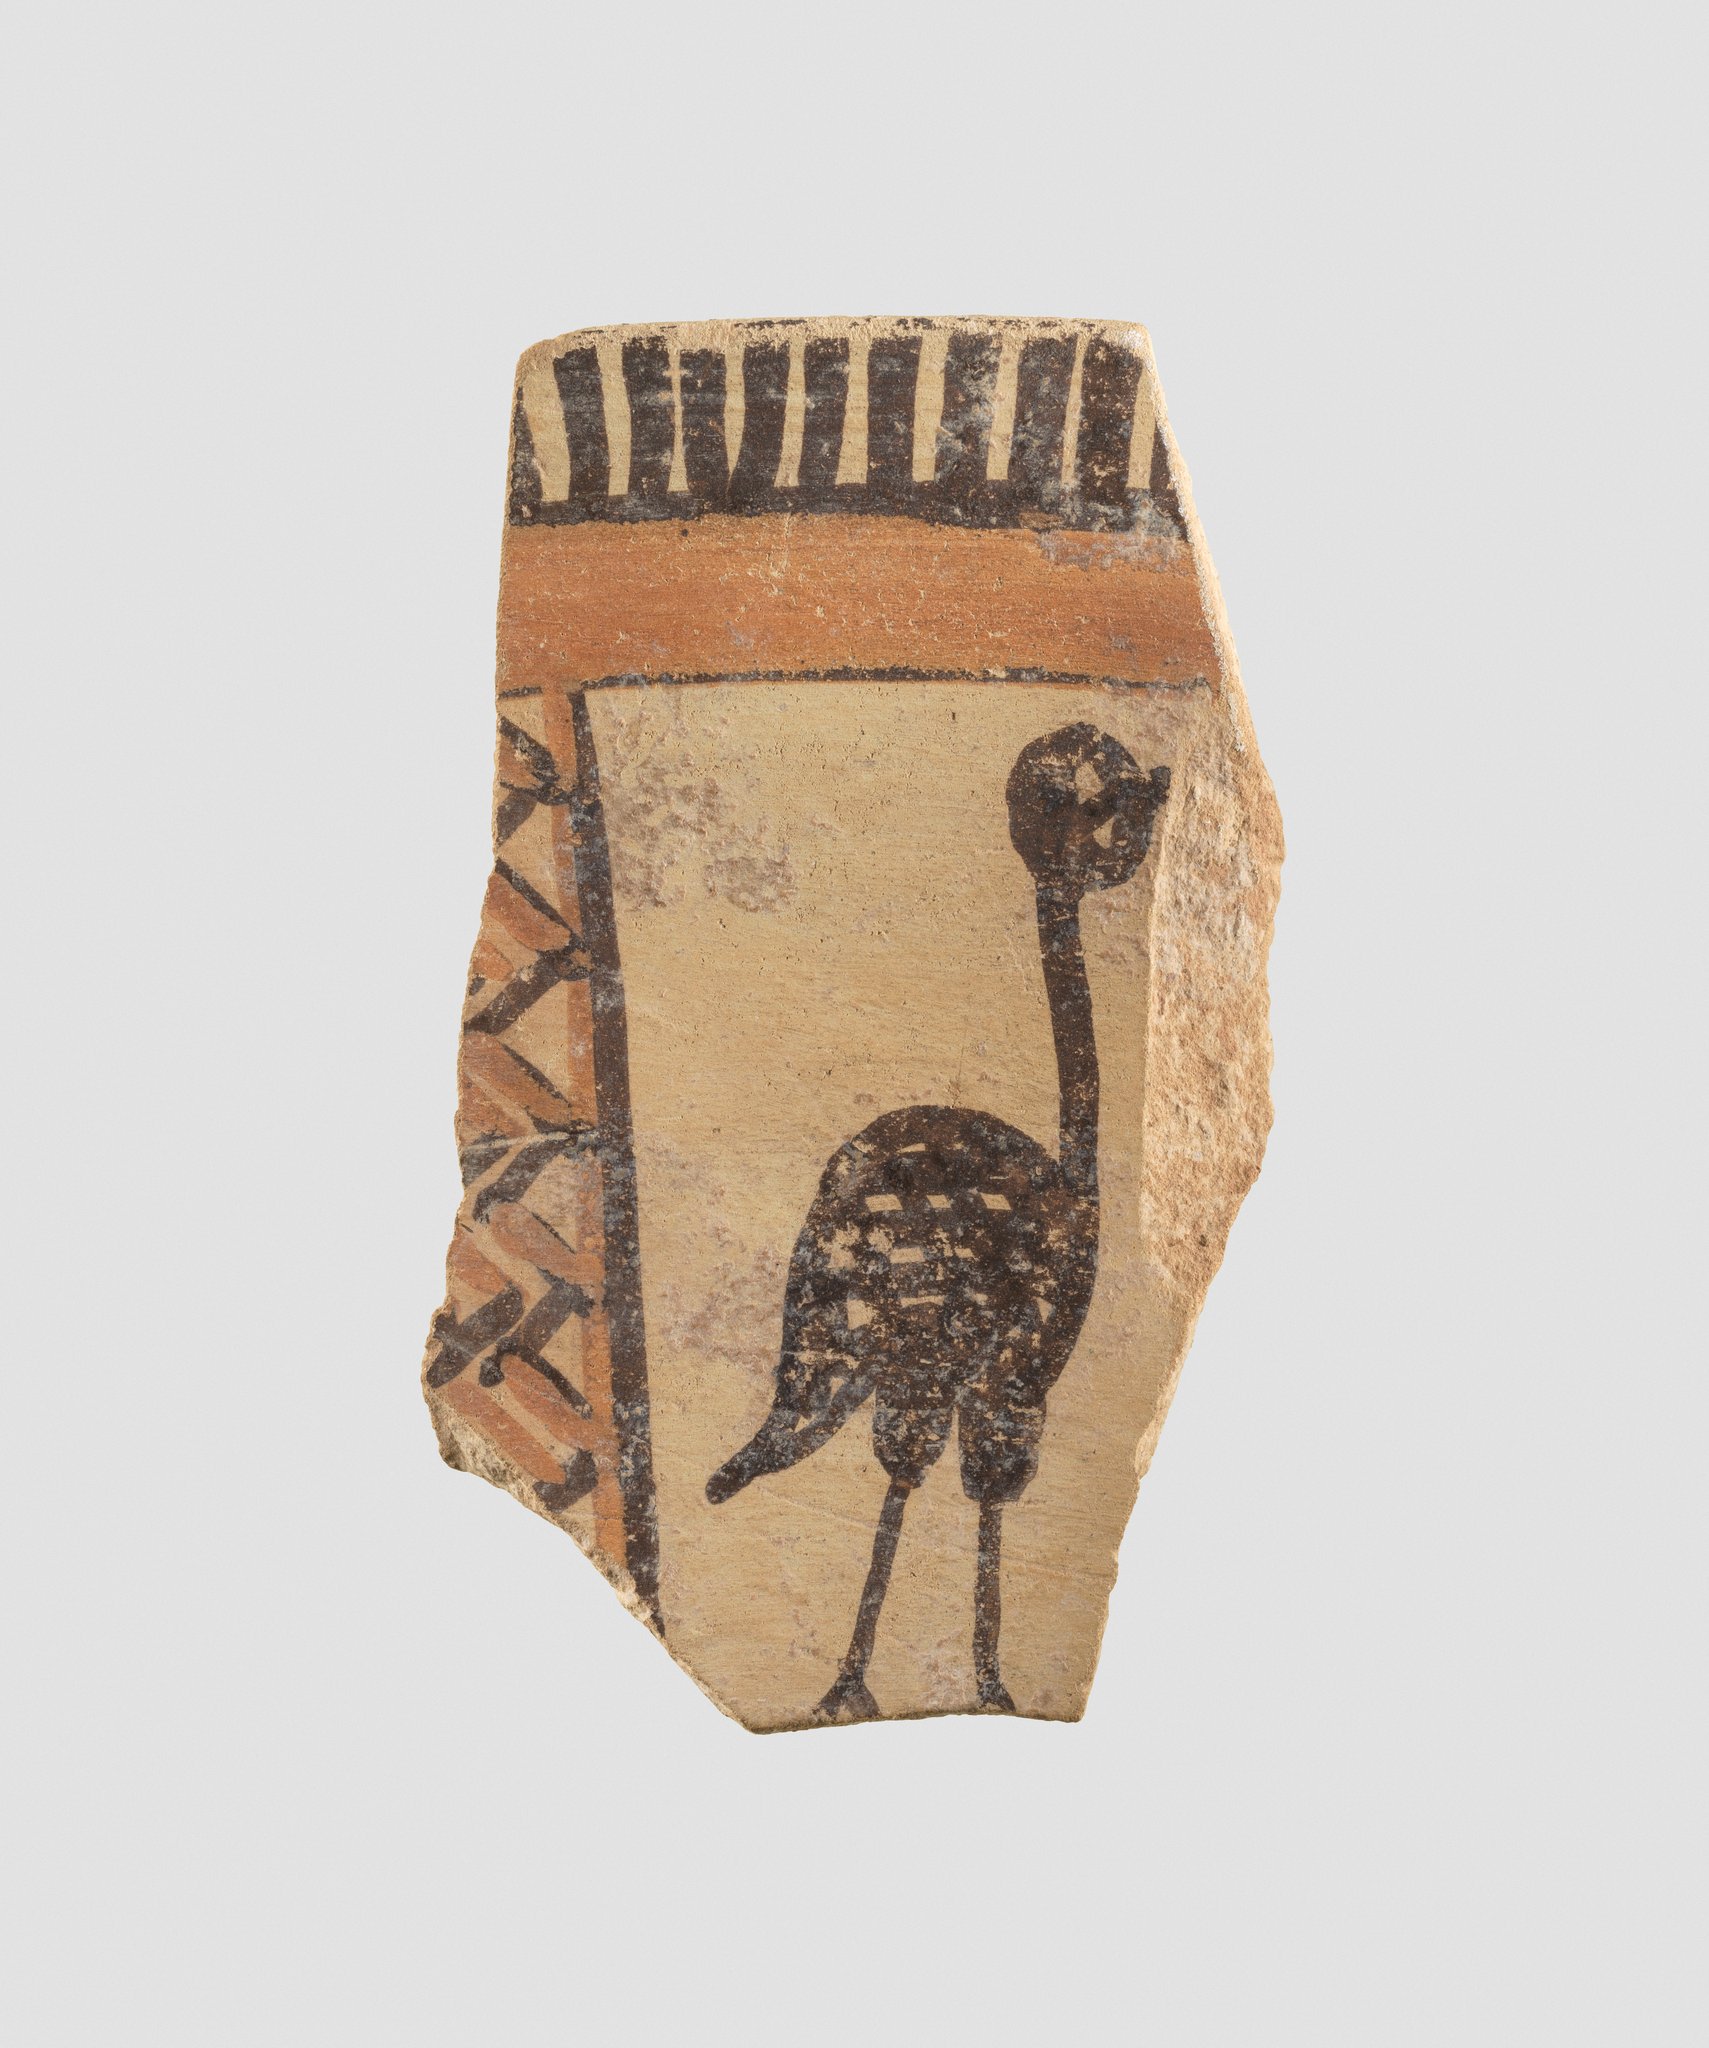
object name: sherd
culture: halaf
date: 5600-5000 BCE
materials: ceramic, paint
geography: syria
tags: birds